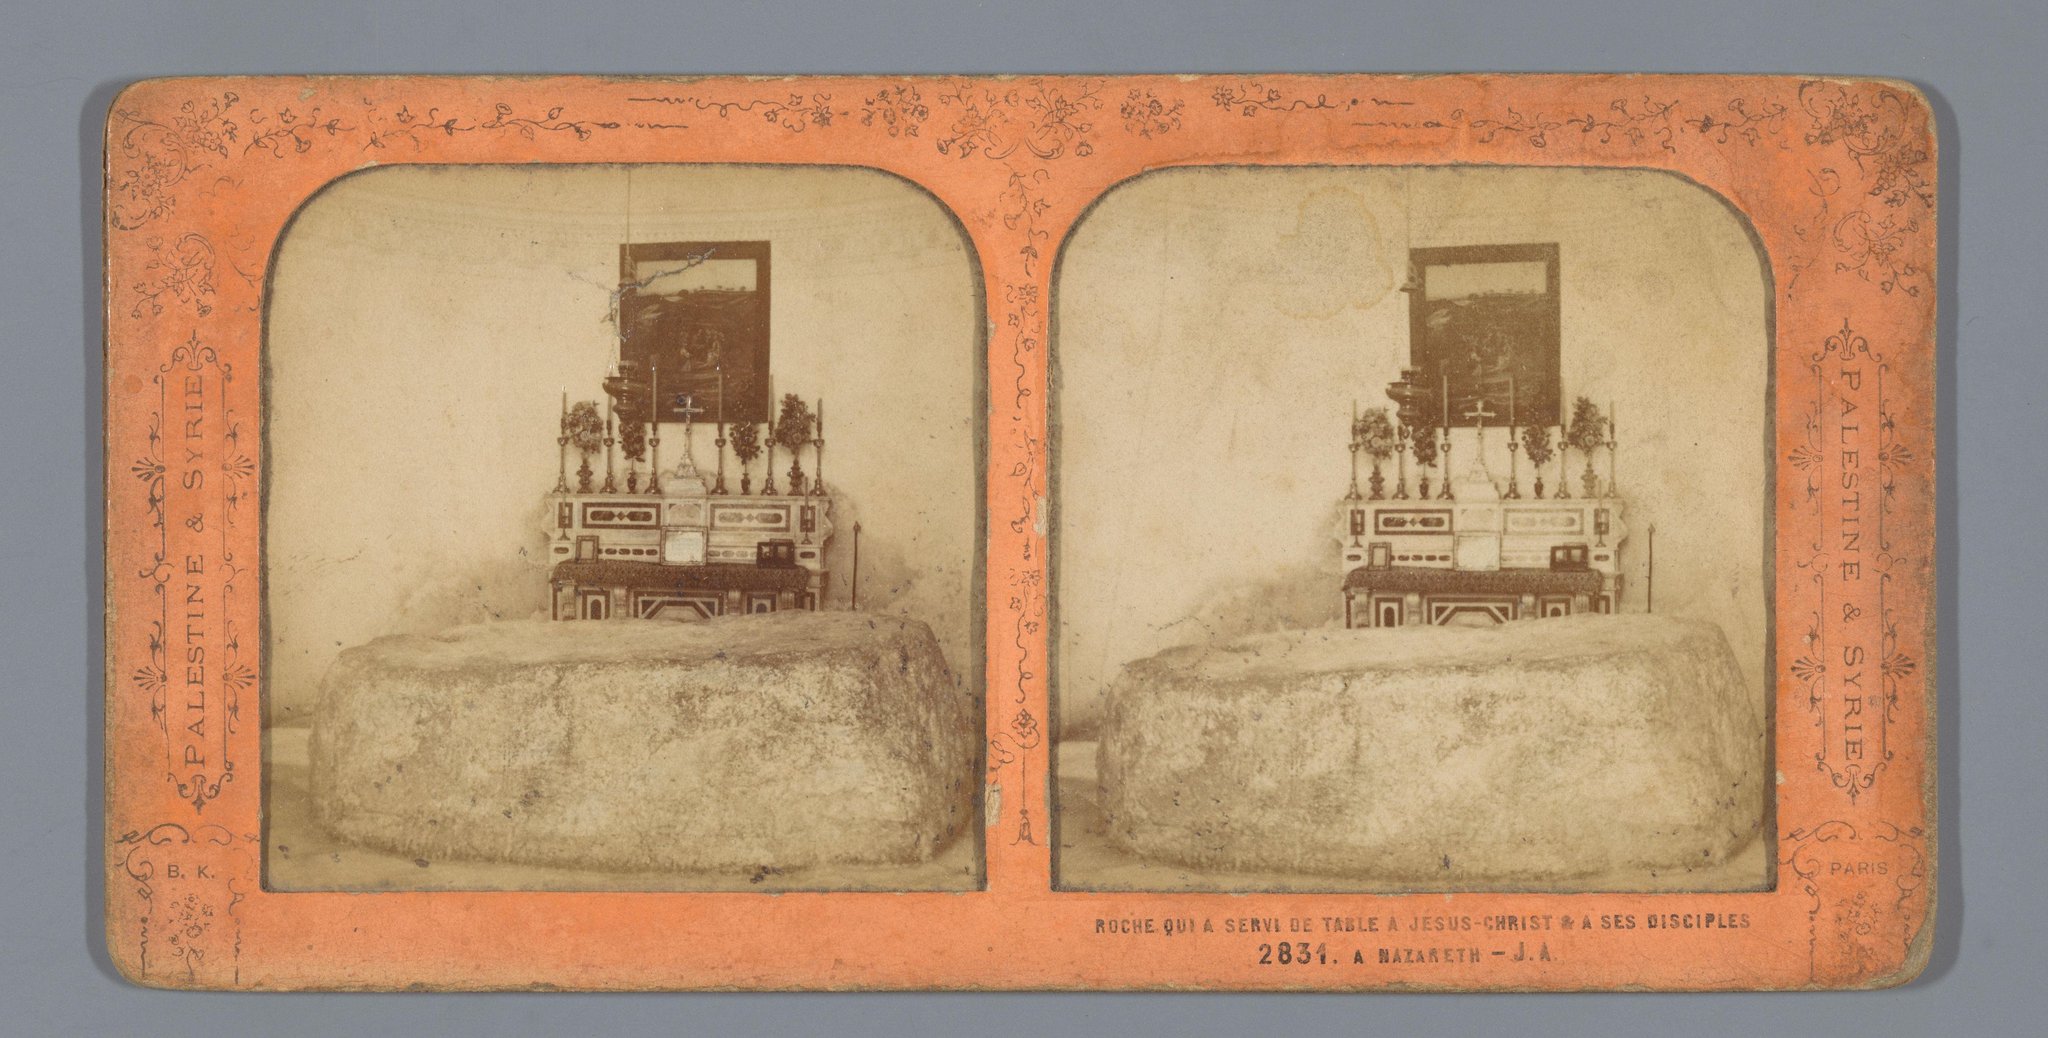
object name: tissue stereograph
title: Palestine & Syrie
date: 1872-1876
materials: cardboard, paper, photographic support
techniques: albumen print, hand coloring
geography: nazareth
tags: table, rocks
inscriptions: monogram: ‘B. K.’, number: ‘2831’, monogram: ‘J. A.’, inscription: ‘PARIS’